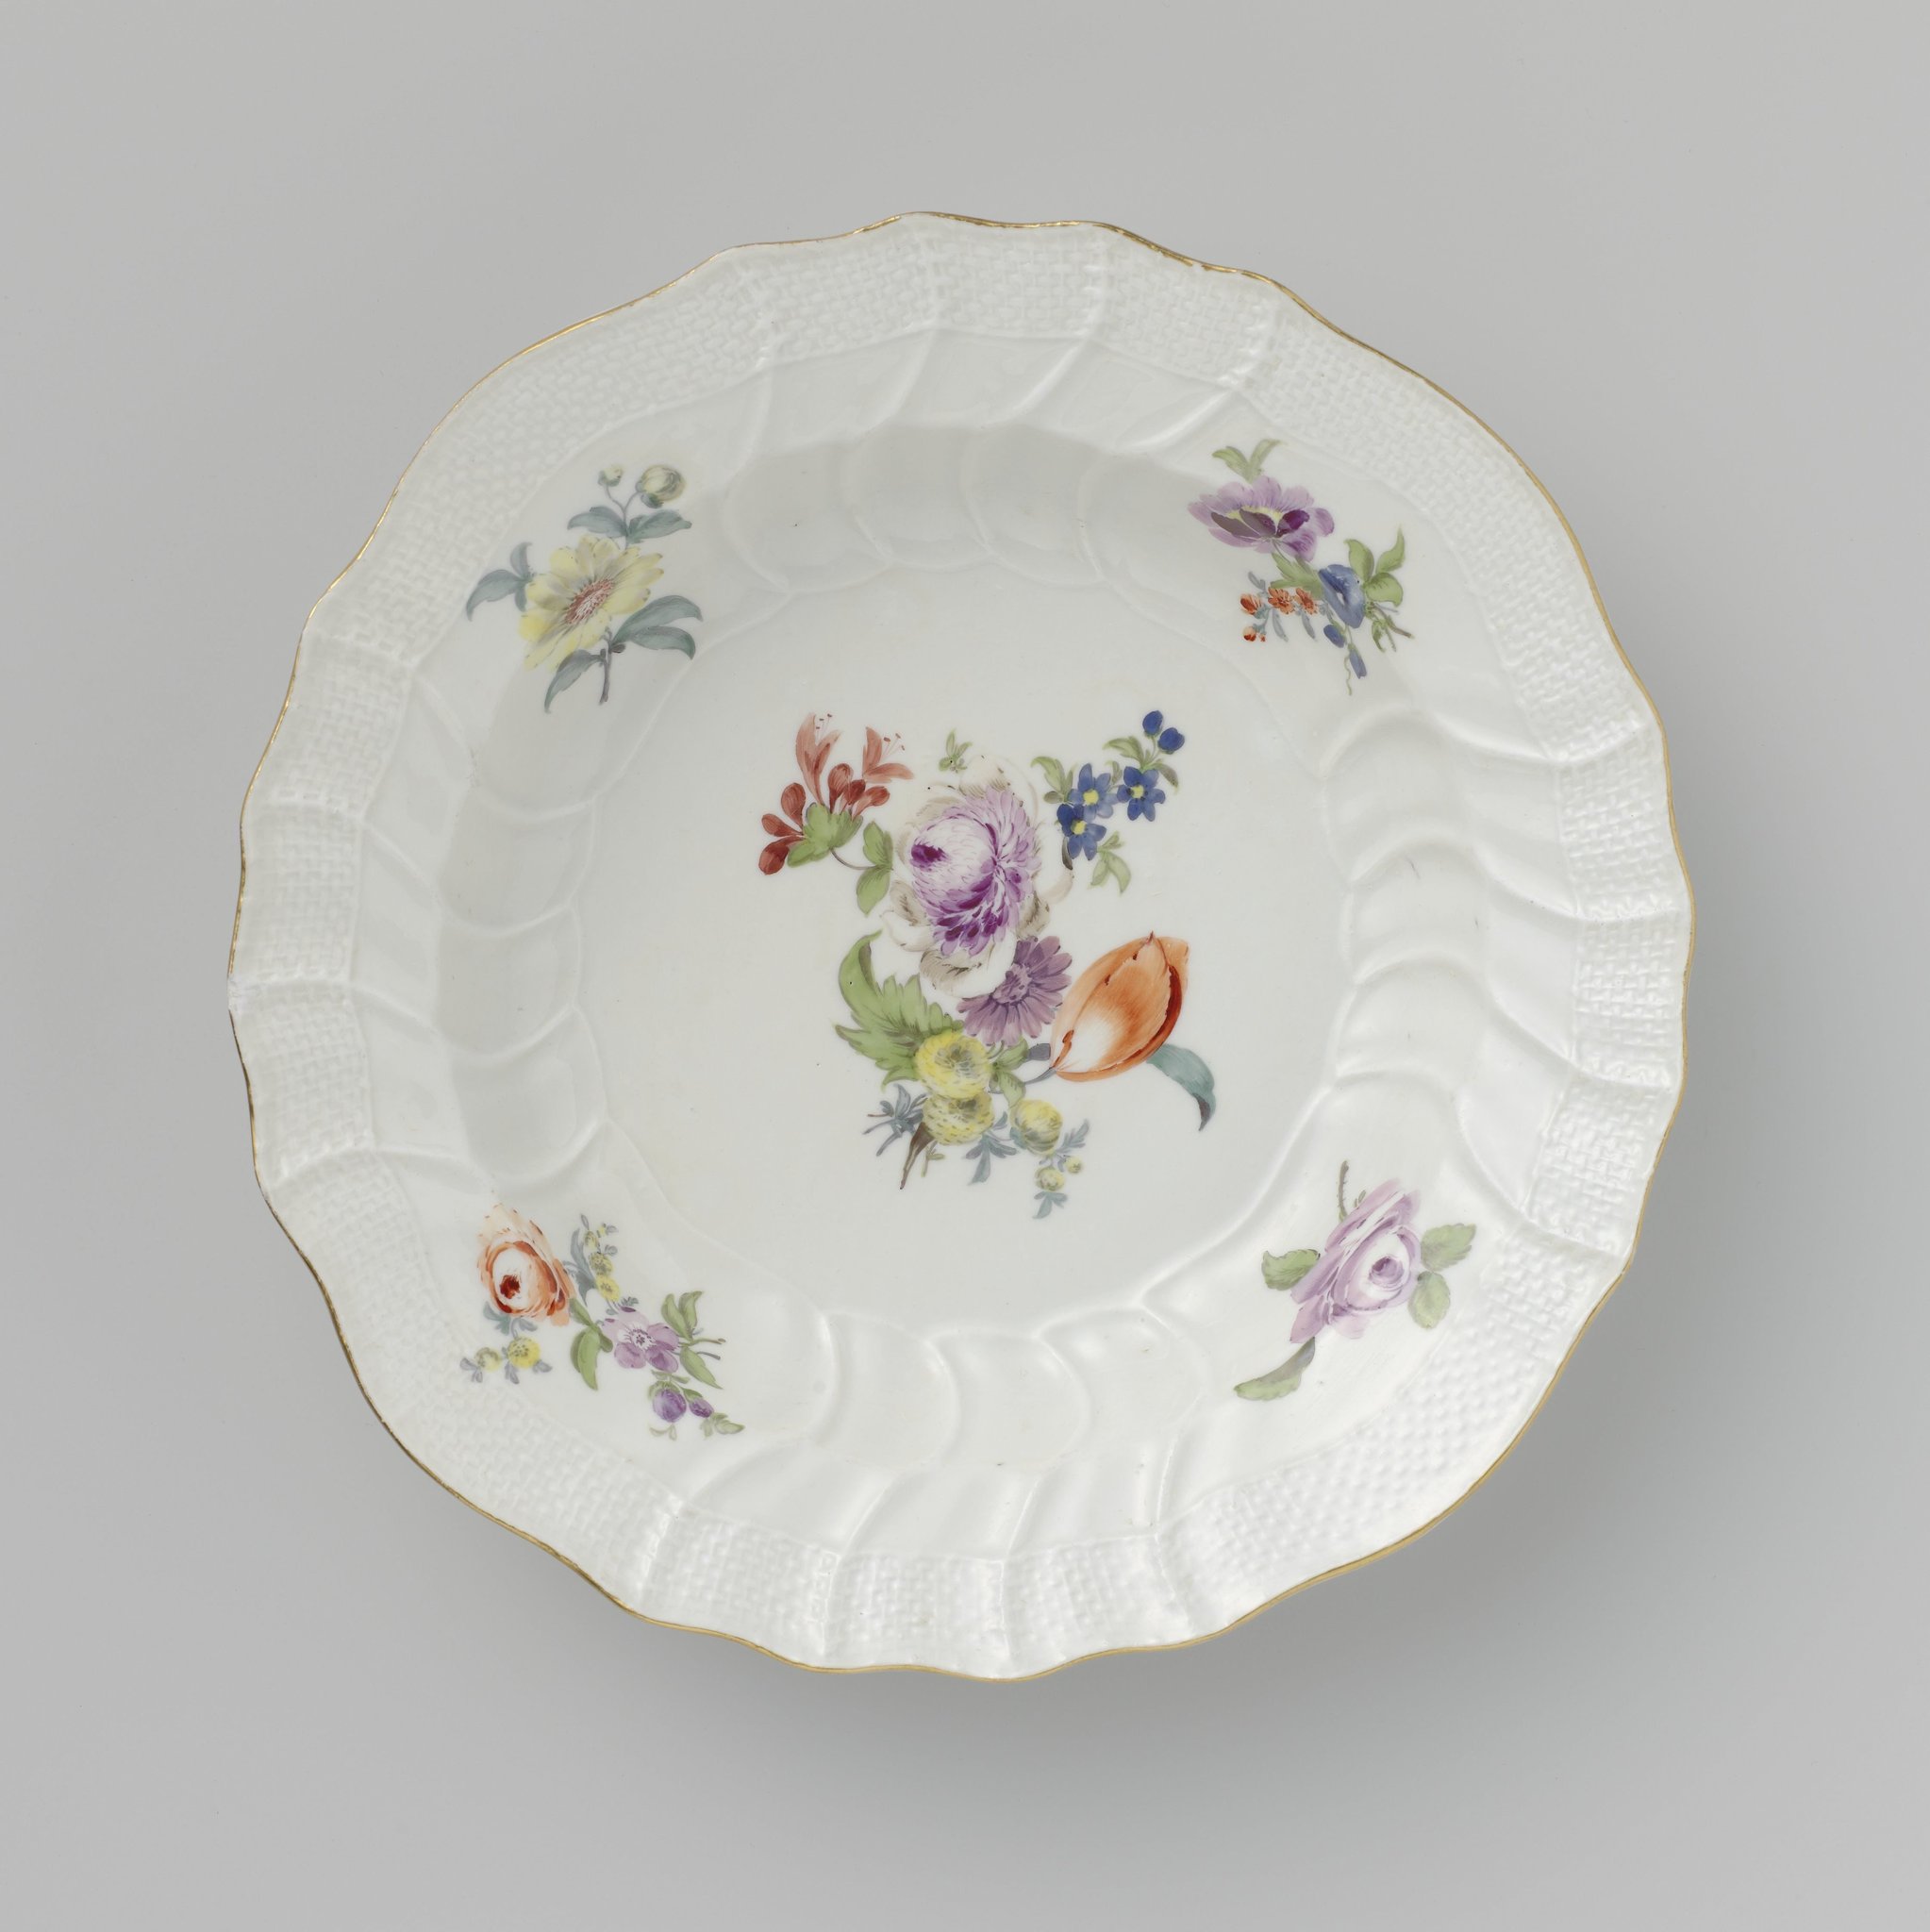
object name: plate dish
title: Bord, veelkleurig beschilderd met Deutsche Blumen, insekten en vruchten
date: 1750-1760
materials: porcelain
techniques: painted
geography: meissen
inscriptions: factory mark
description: Rond soepbord van beschilderd porselein. Het bord is beschilderd met Deutsche Blumen, insekten en vruchten. De rand is in reliëf versierd met het Neuozier-patroon. Het bord is gemerkt en hoort bij een servies (BK-17474-1 t/m BK-17474-253).